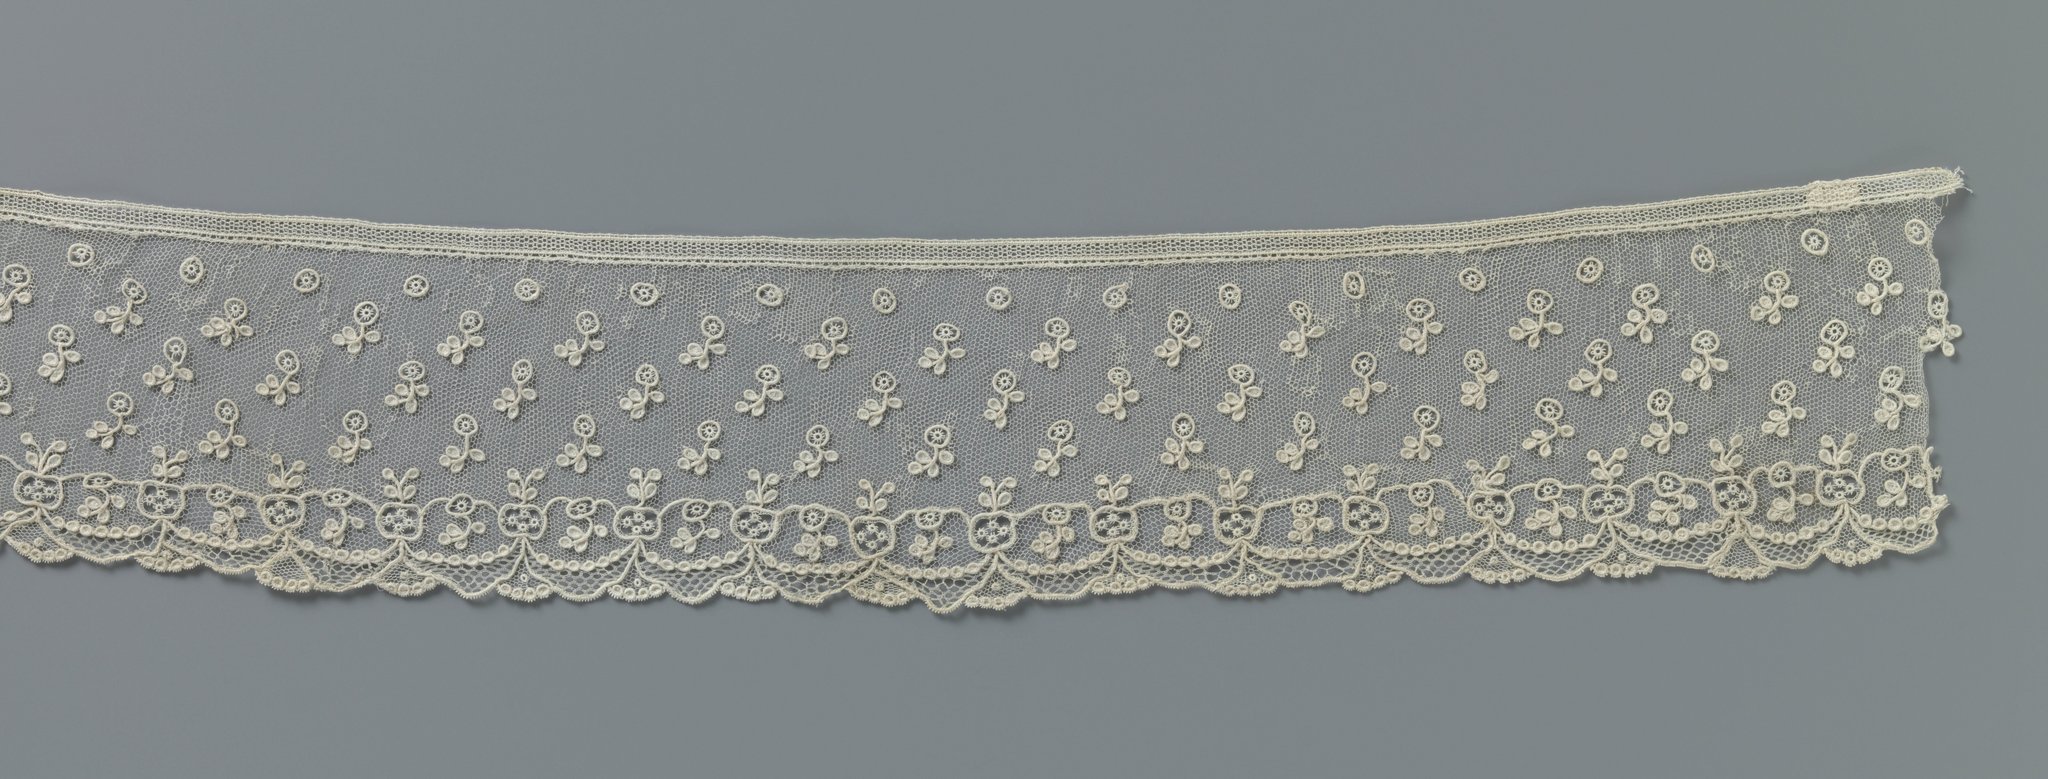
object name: strip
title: Strook naaldkant met vallende bloesem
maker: Anonymous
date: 1780-1790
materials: linen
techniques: lace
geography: france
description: Op het veld staan in schuine rijen geplaatste cirkelvormige bloempjes met een neerhangend takje. Staande boogjes, steunende op ronde medaillons vormen een randje te zamen met een driedubbele boogjesslinger. Alençon-kant